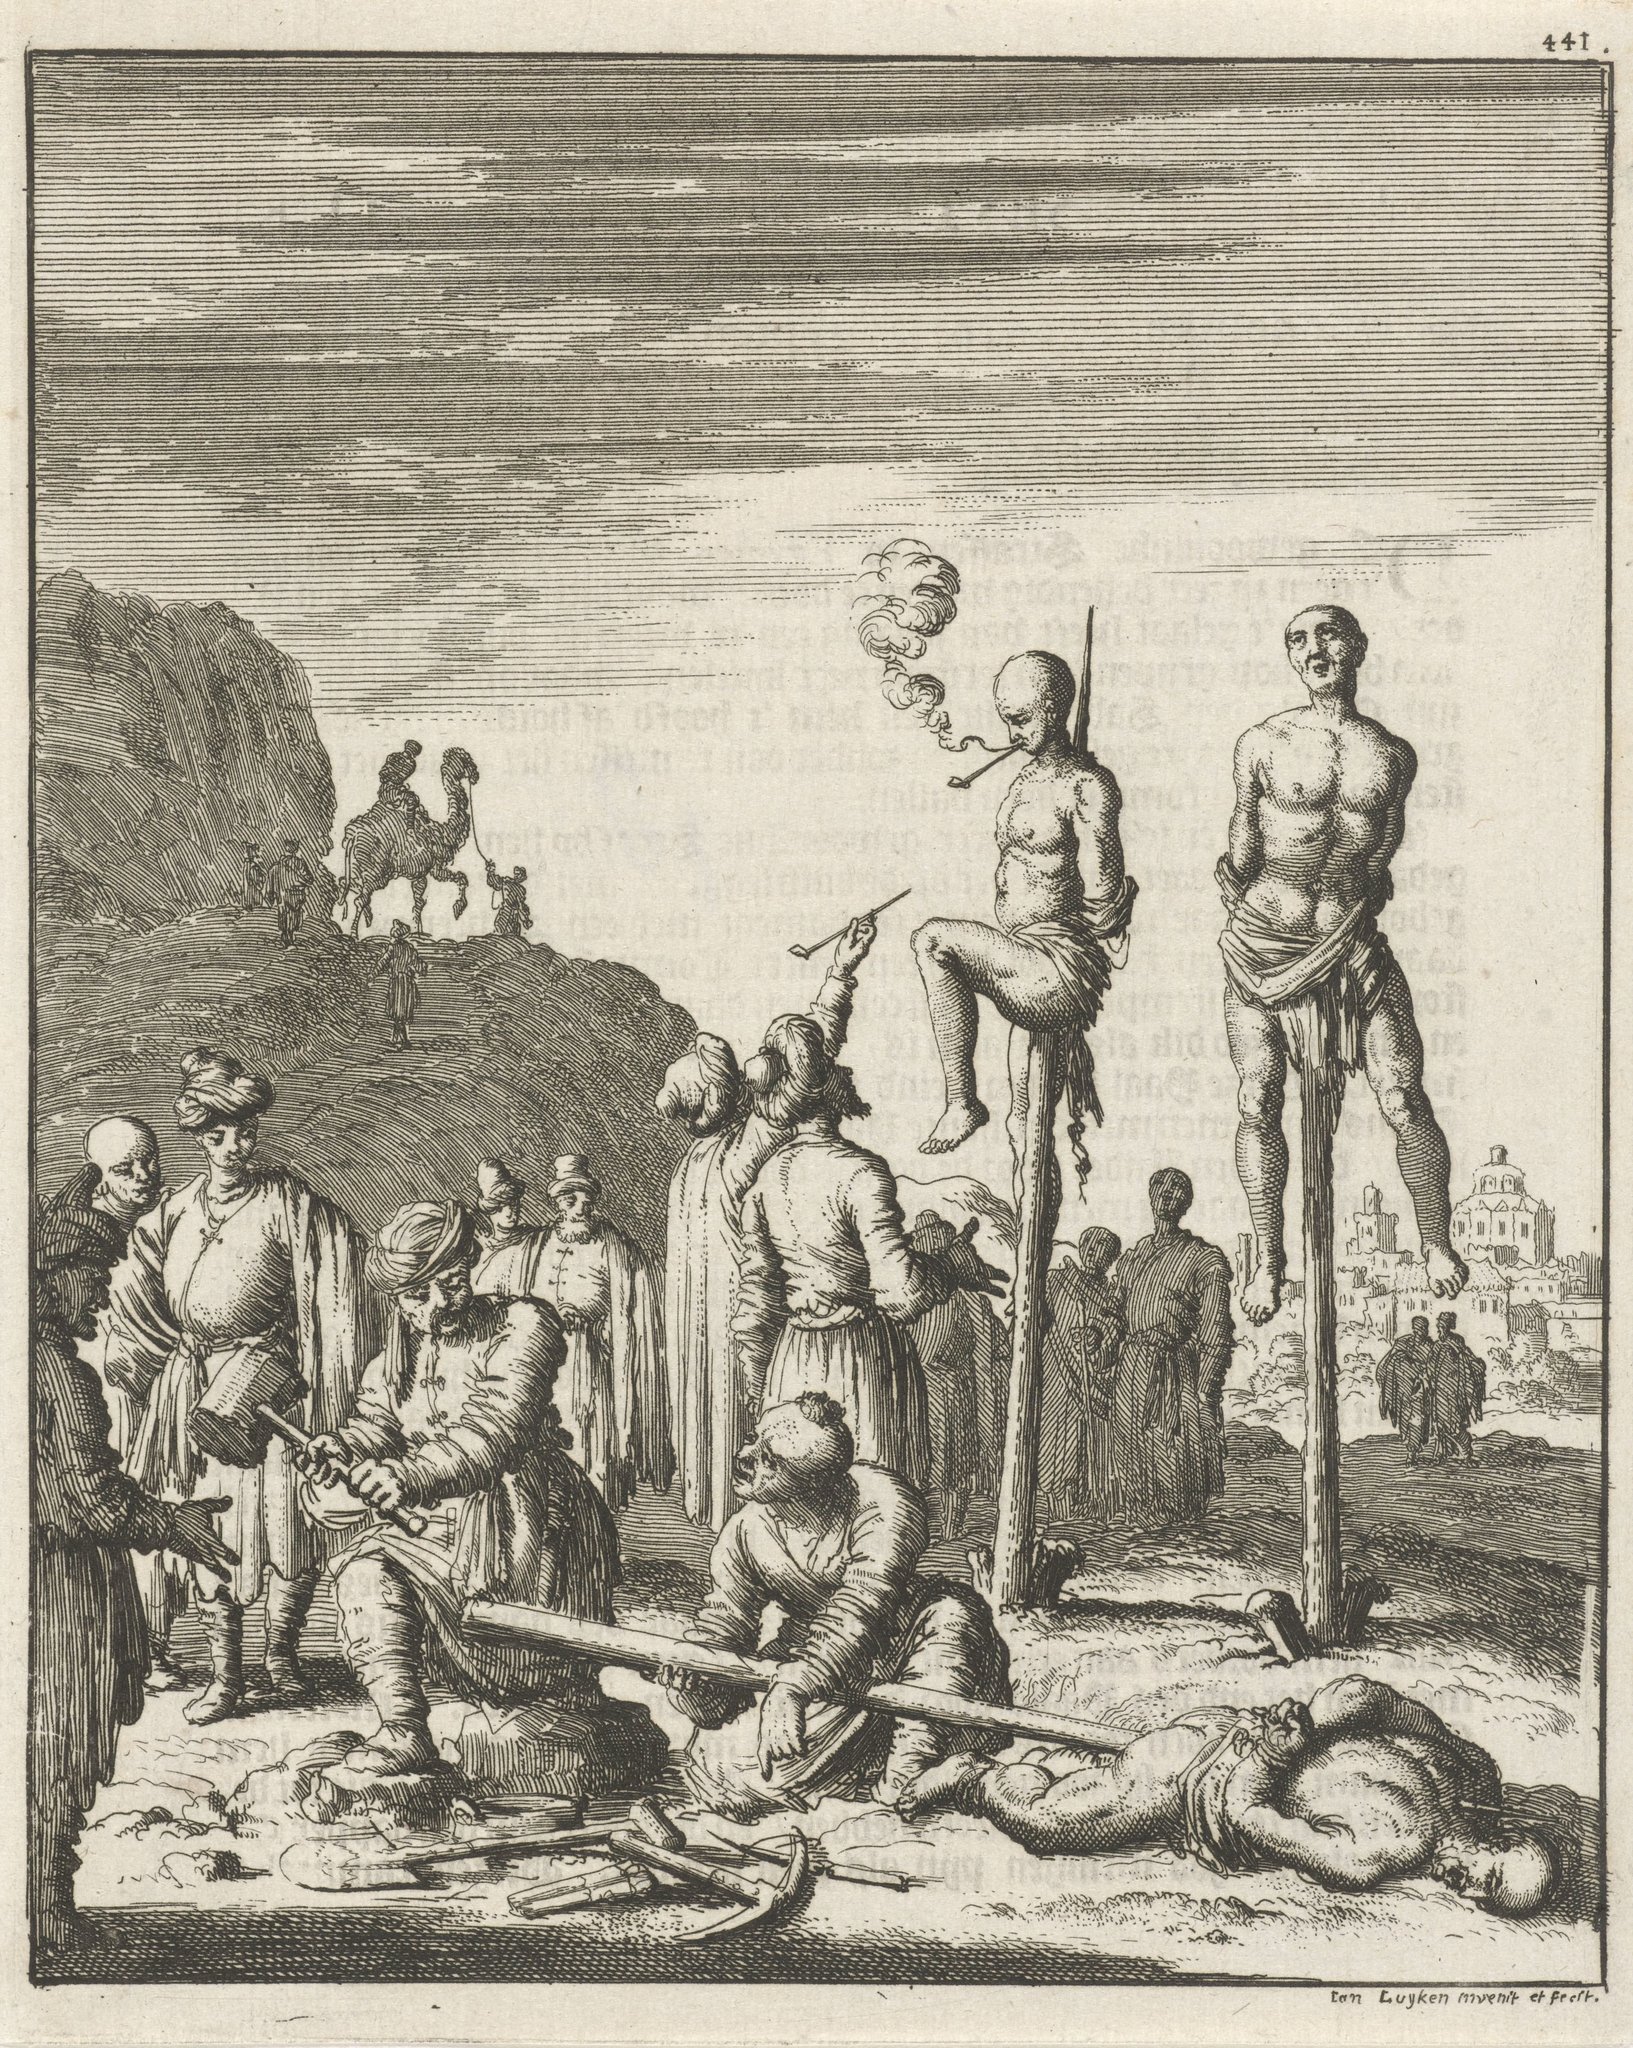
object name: print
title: Figuren voor straf aan een paal gespietst in Egypte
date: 1681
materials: paper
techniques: etching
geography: amsterdam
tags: instruments of torture, execution or punishment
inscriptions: collector's mark: Lugt 2228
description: Illustratie opgenomen in deel I van: Thevenot, Jean de. Gedenkwaardige en zeer naauwkeurige reizen van den heere de Thevenot. Amsterdam: Jan Bouman, 1681-1682.